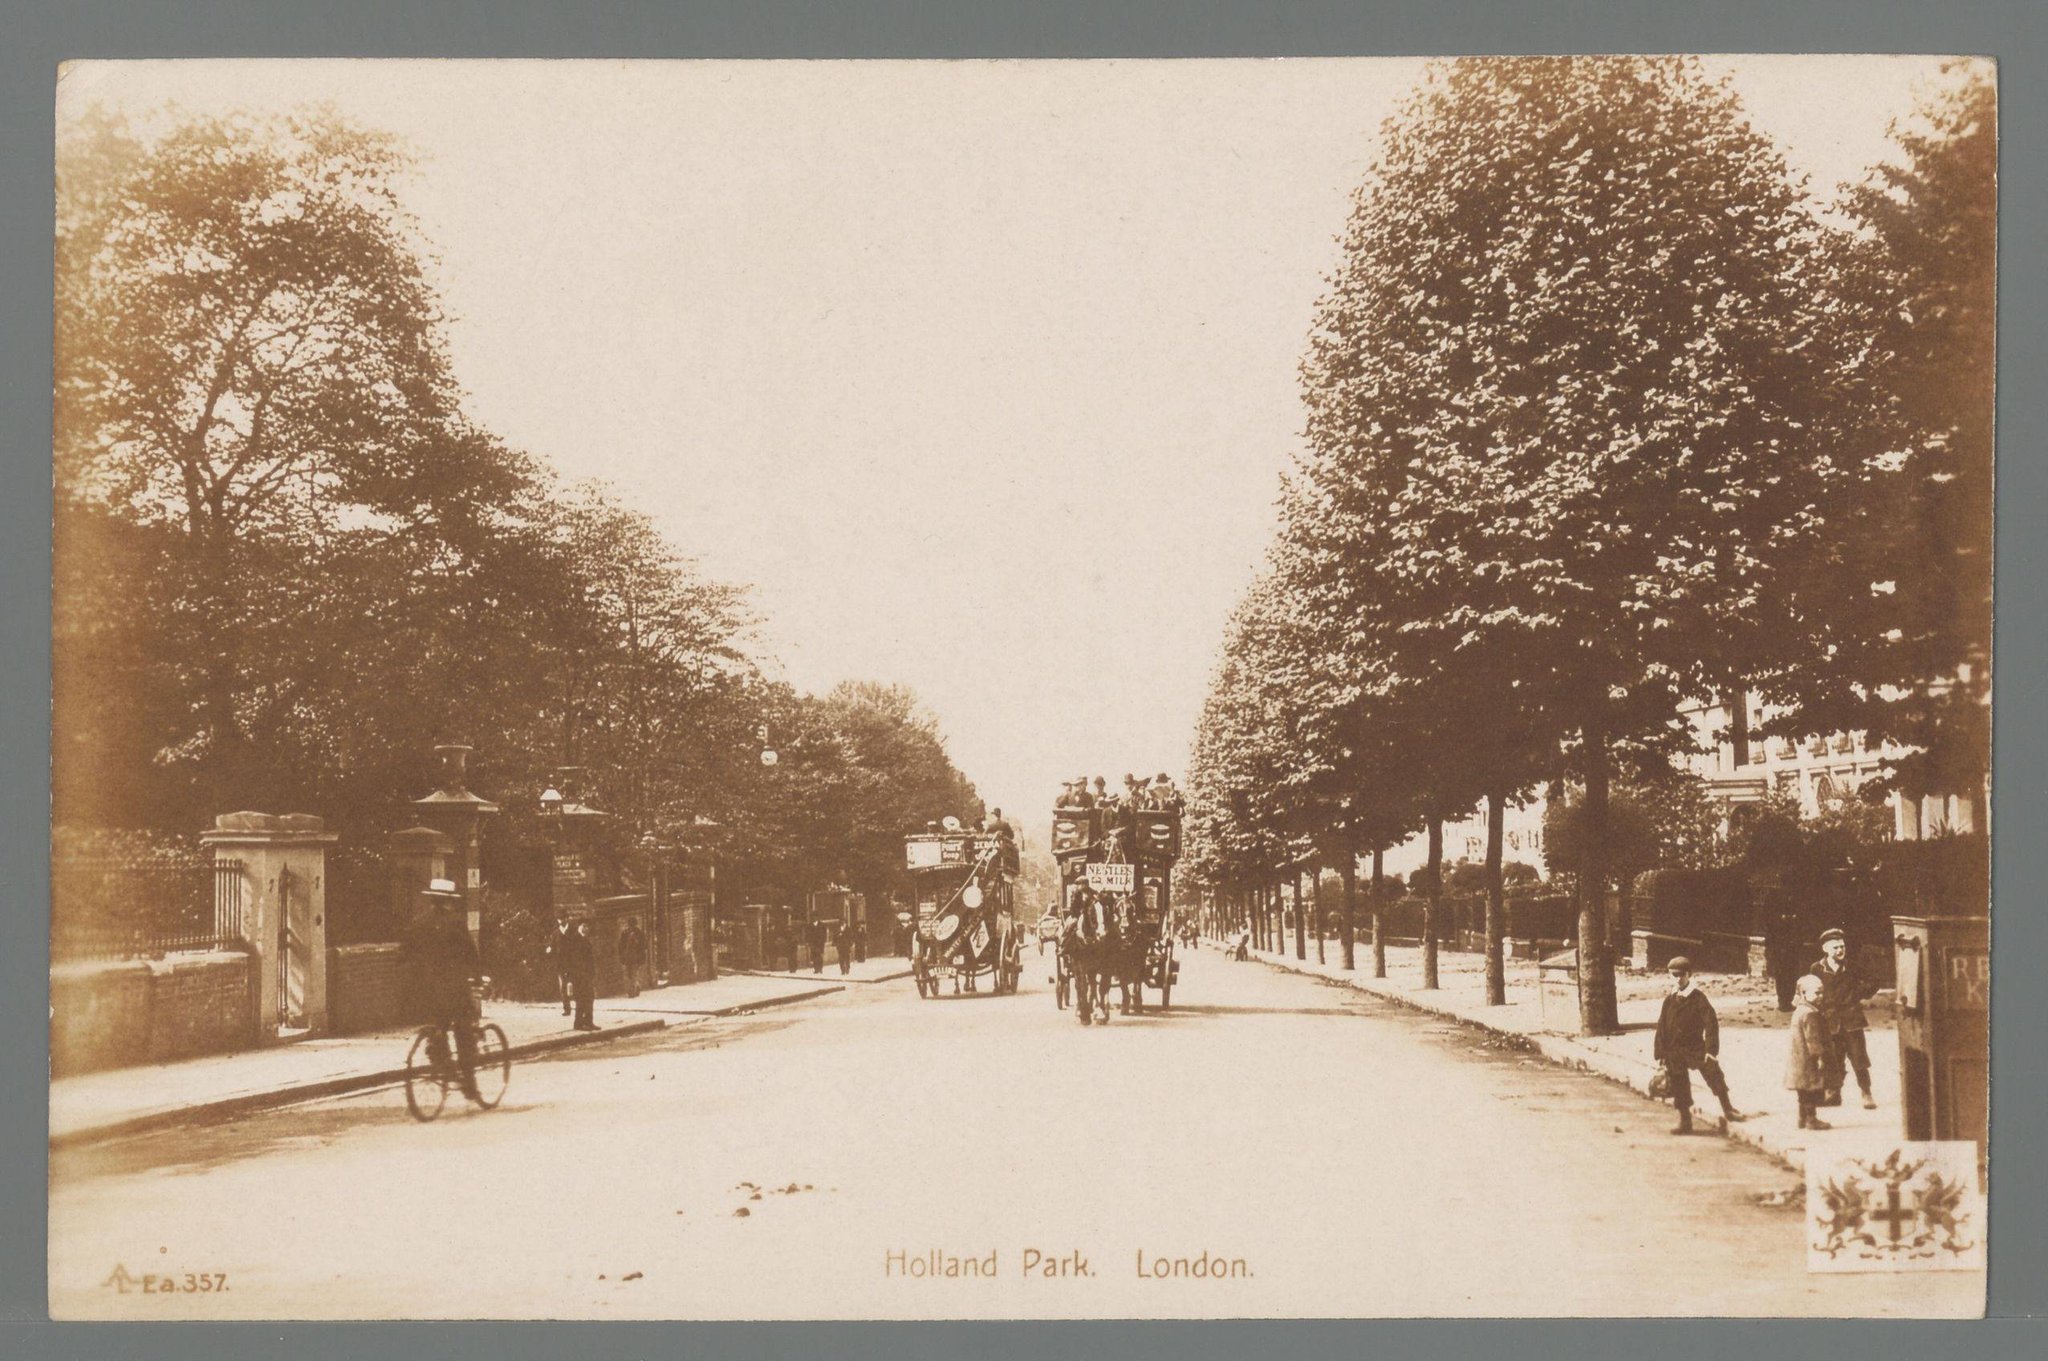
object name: photograph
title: Holland Park. London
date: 1902-1940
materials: paper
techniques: gelatin silver print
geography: london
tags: coat of arms (as symbol of the state, etc.), diligence, omnibus, horse-tram, park